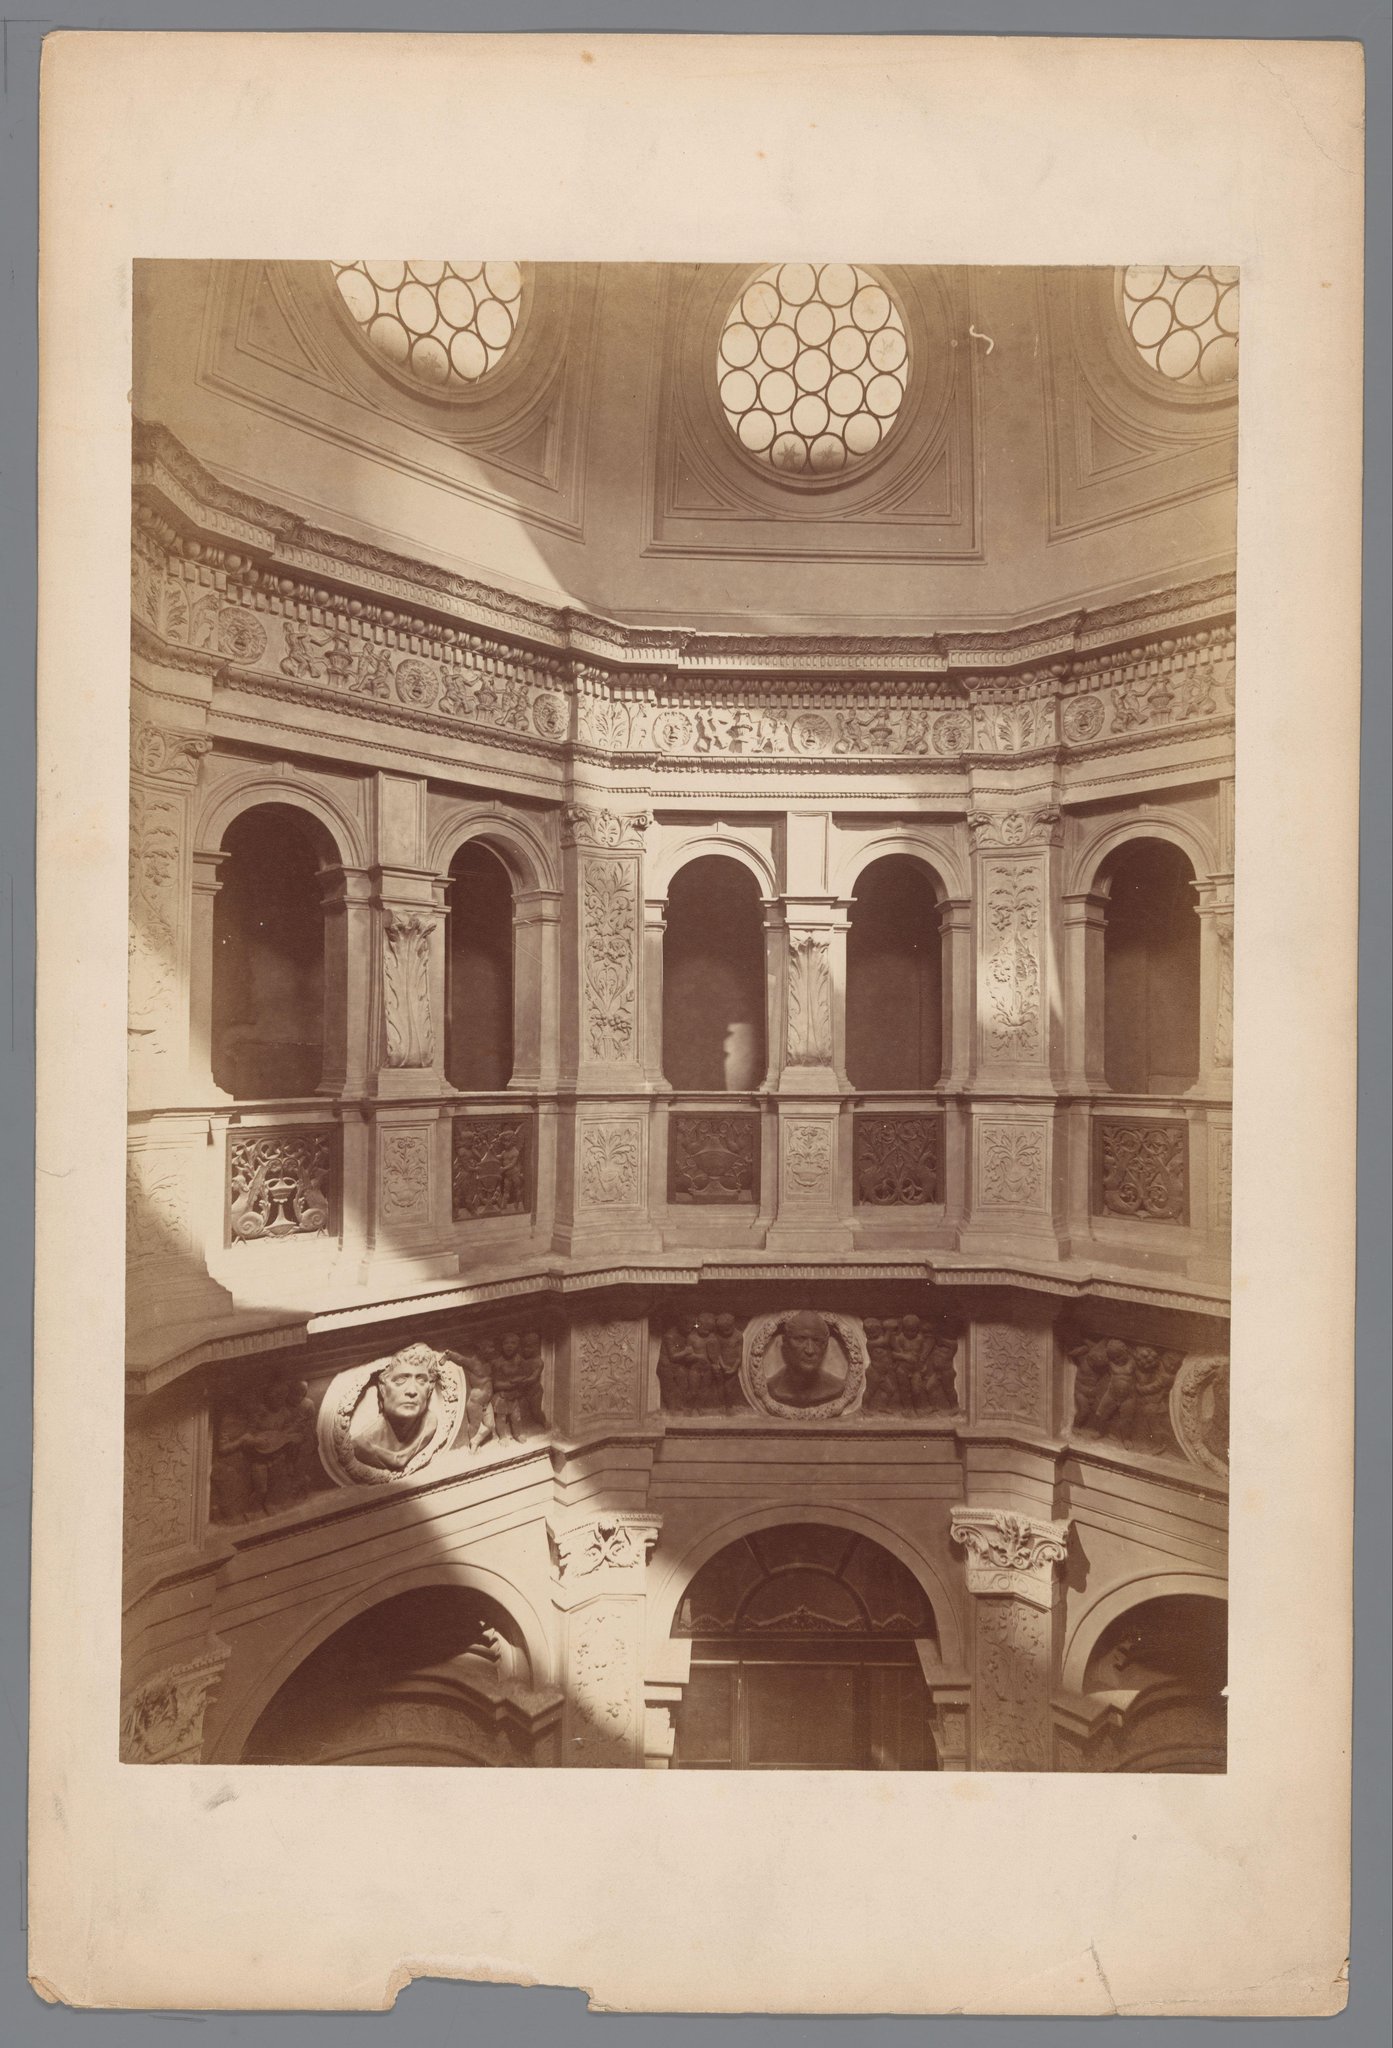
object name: photograph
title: Interieur van een koepel gedecoreerd met busten en plantmotief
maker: pompeo pozzi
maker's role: fotograaf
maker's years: 1817-1880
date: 1875-1900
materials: cardboard, photographic support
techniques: albumen print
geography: europe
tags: chest, bust, dome ~ architecture, ornament derived from plant forms, europe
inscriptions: collector's mark: Lugt 3937